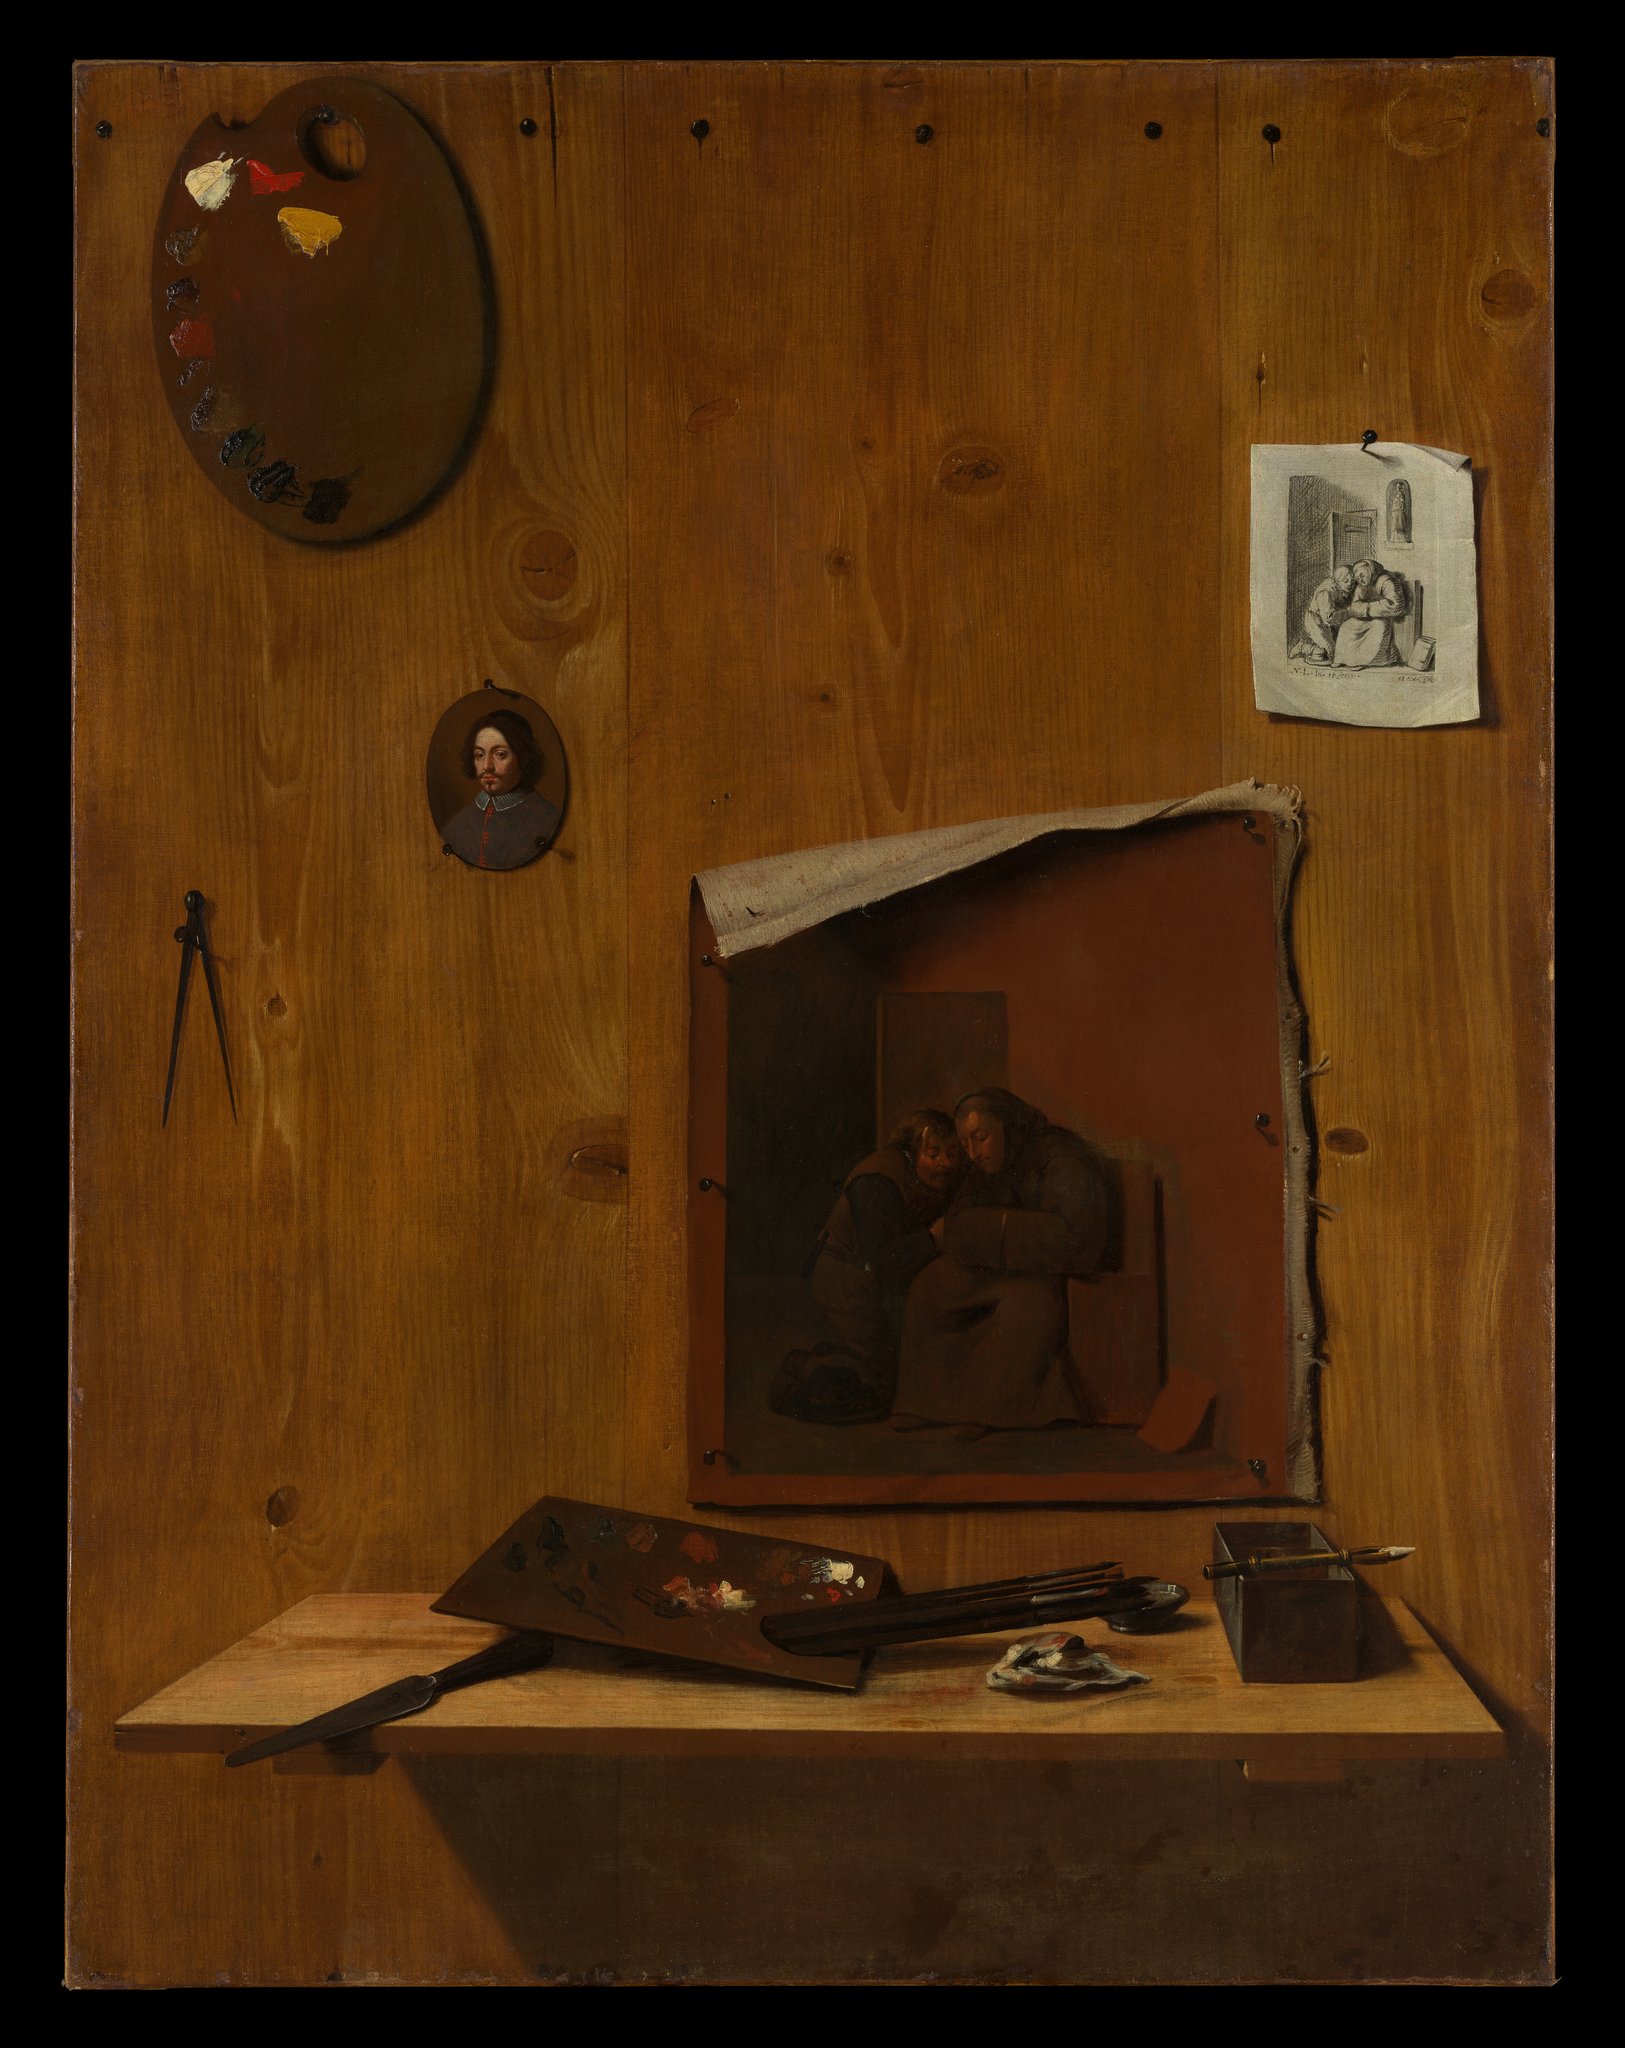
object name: painting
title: Trompe l'oeil with Palettes and Miniature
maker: jean françois de le motte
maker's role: artist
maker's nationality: french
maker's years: 1635-1685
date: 1670-1699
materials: canvas, oil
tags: painting